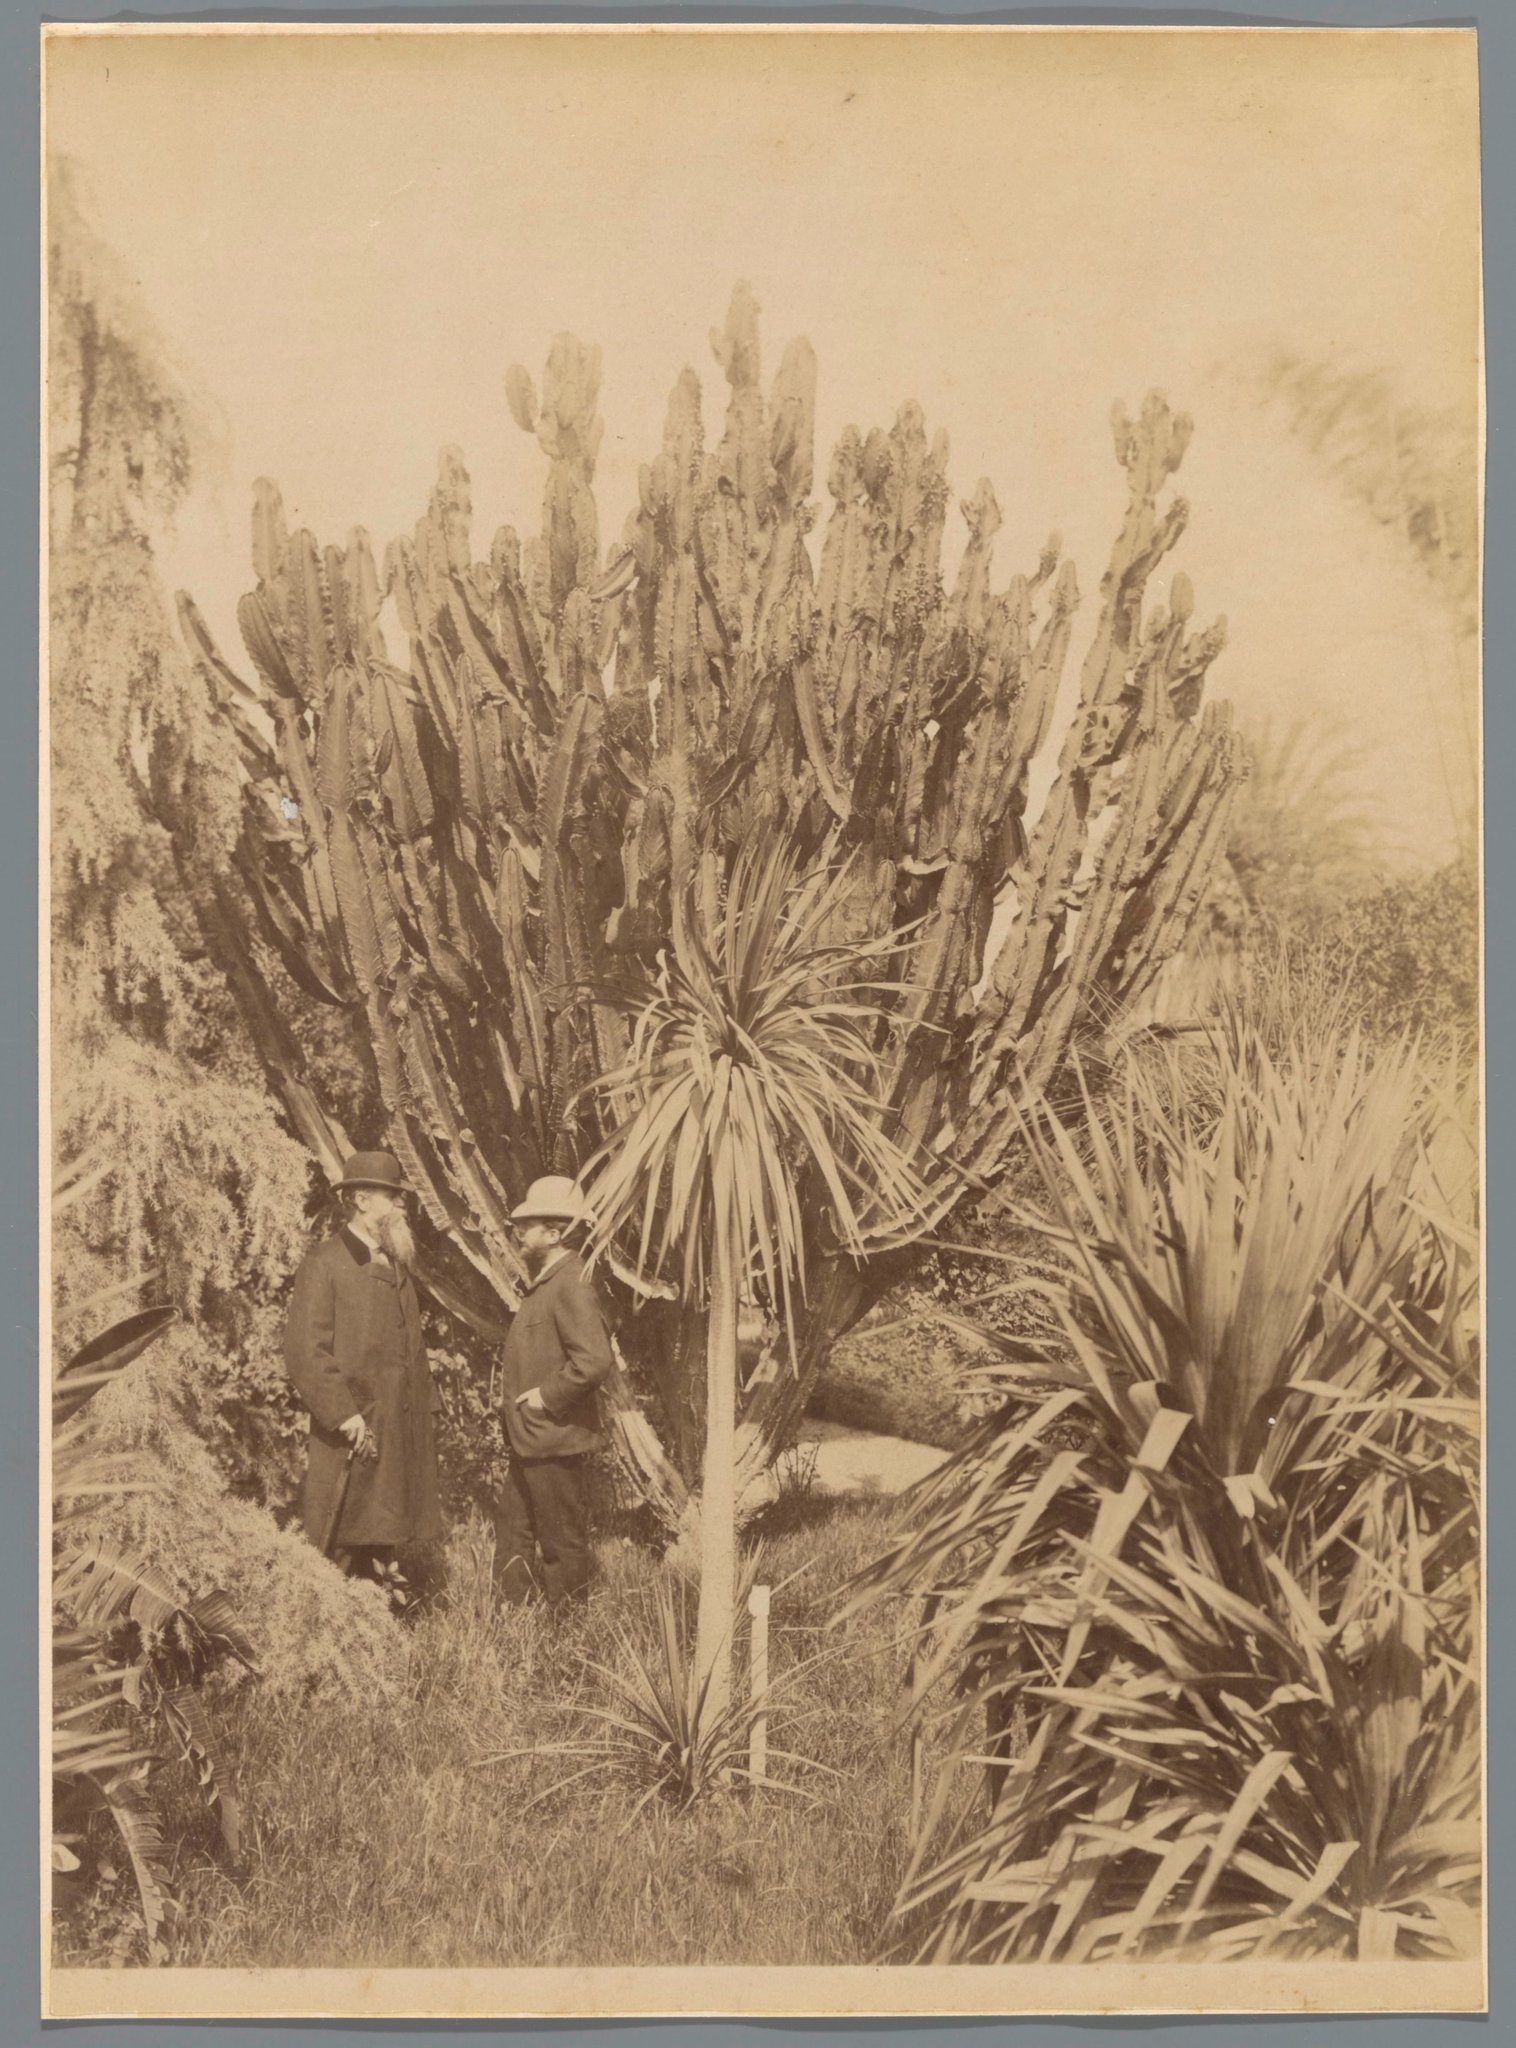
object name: photograph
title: Twee mannen, staande voor een cactus te Palermo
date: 1880-1890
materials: paper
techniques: albumen print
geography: palermo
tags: adult man, plants and herbs: cactus